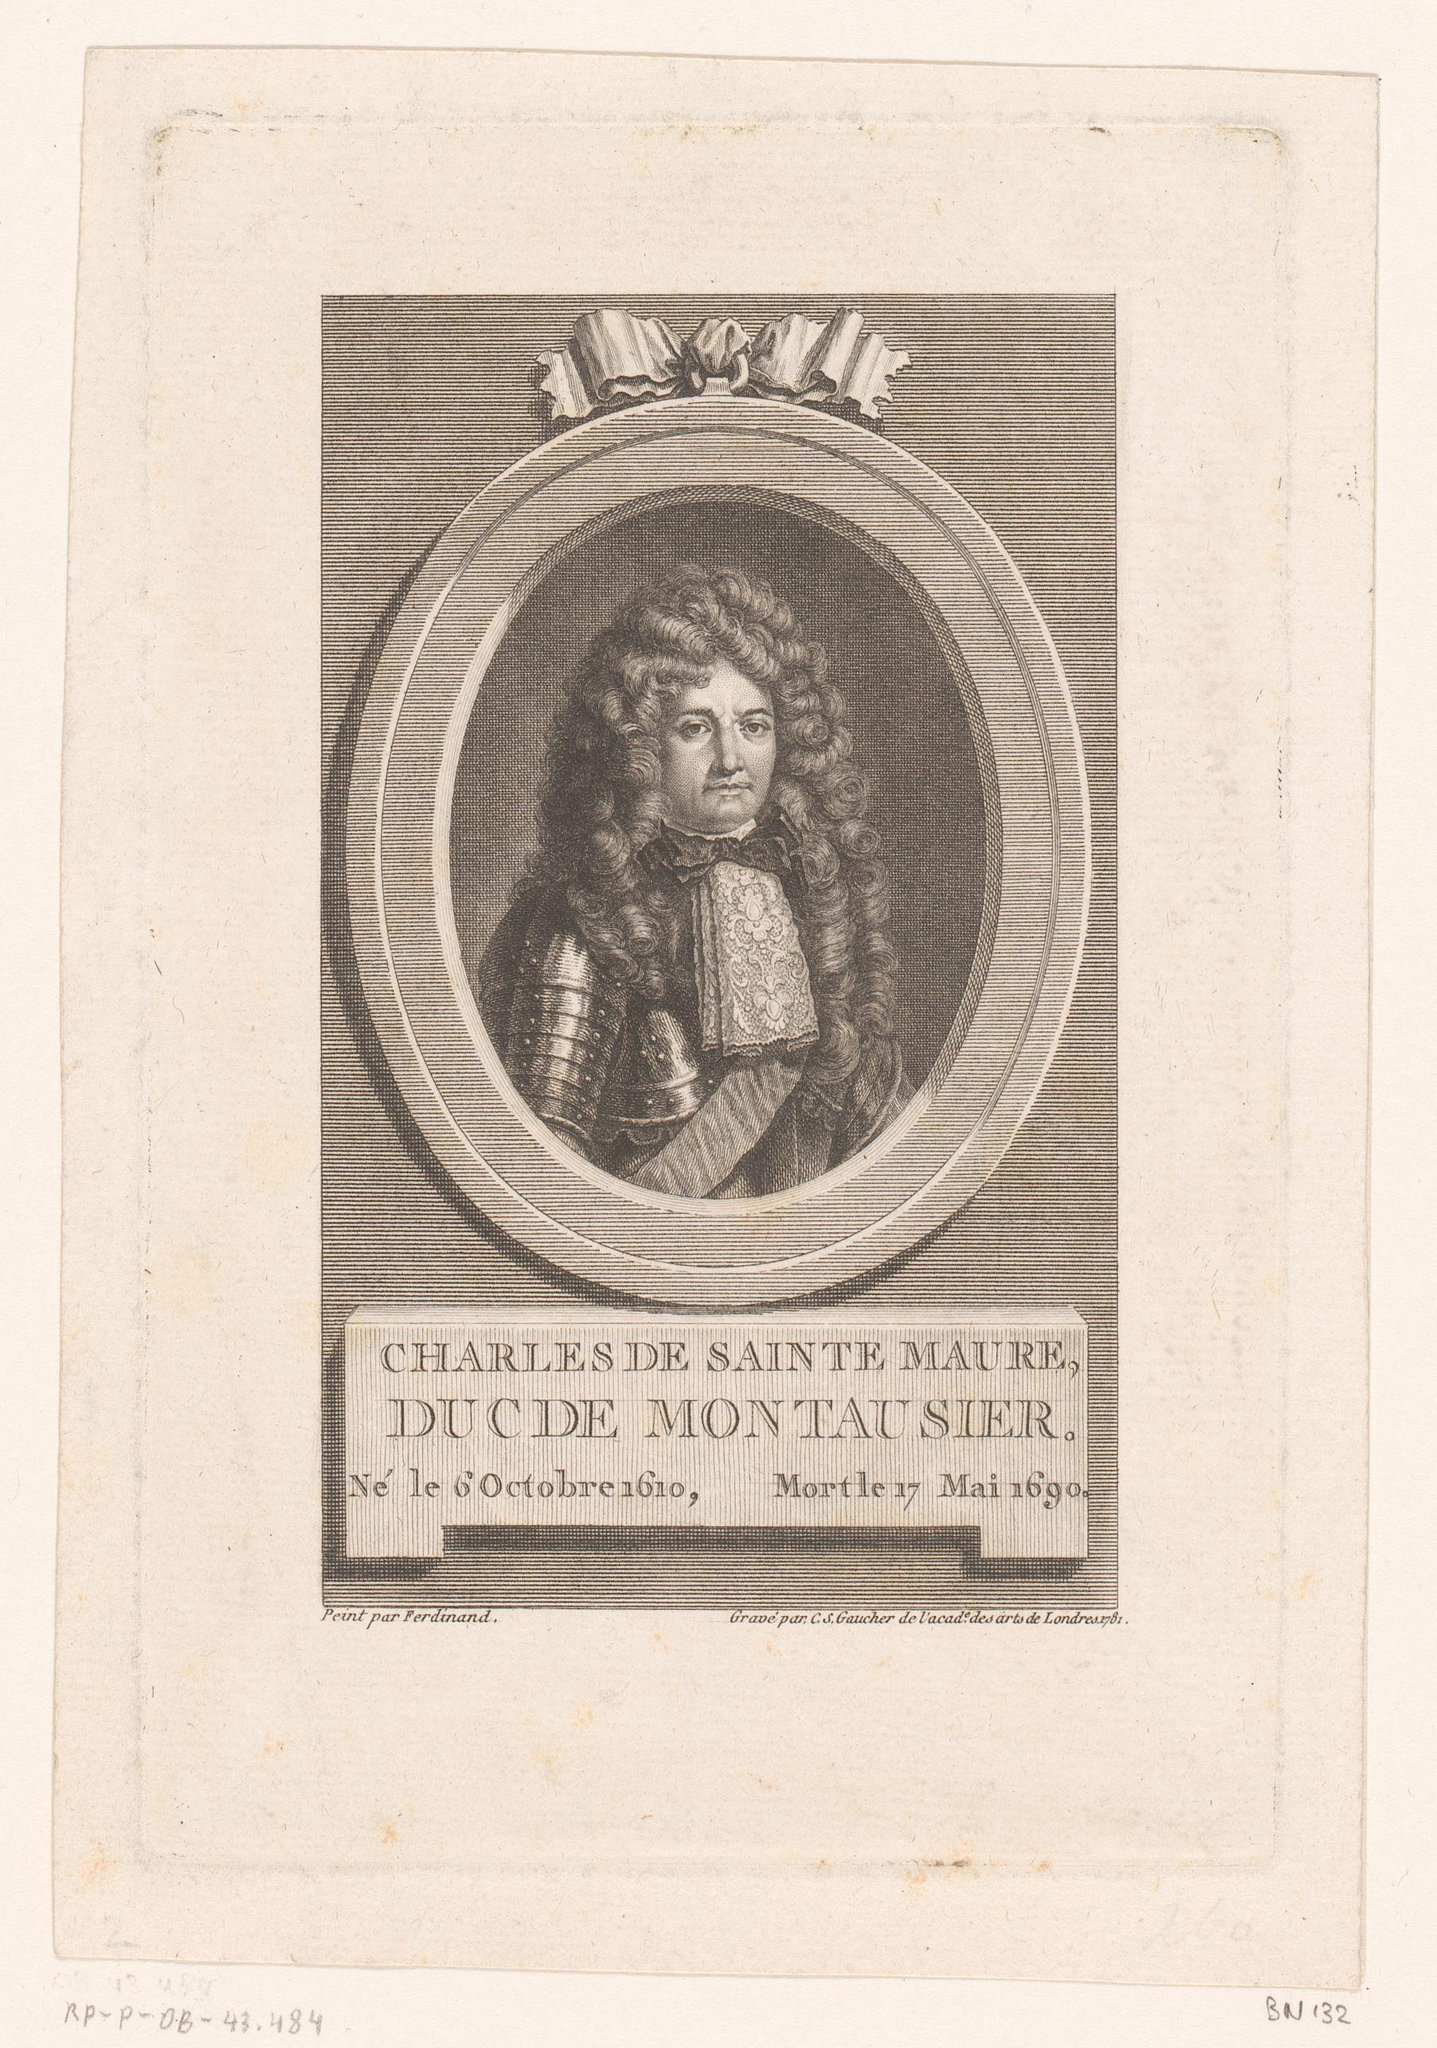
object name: print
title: Portret van Charles de Sainte-Maure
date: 1781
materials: paper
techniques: engraving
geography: london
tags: ornament ~ medallion, historical persons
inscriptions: collector's mark: Lugt 2228